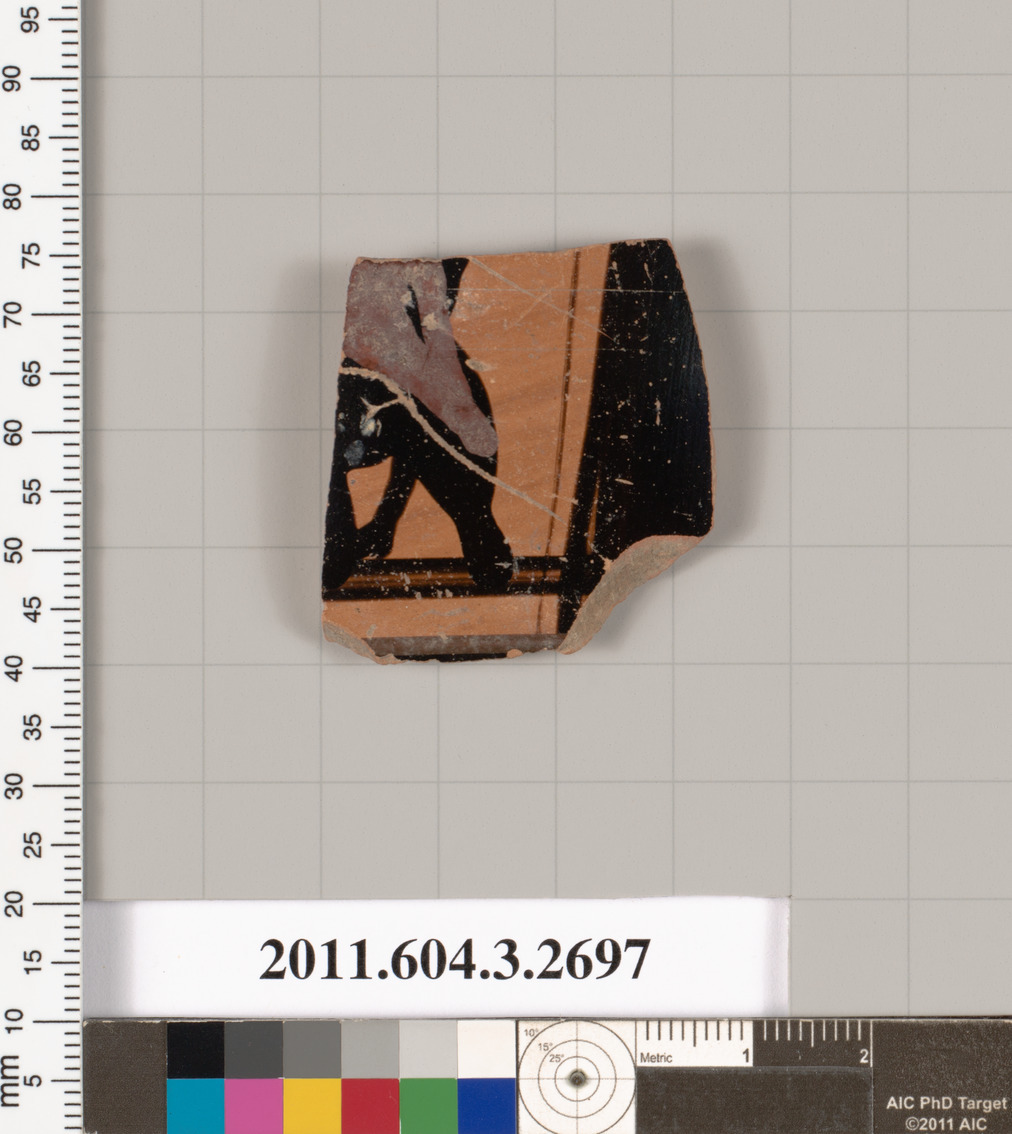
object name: oinochoe fragment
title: Terracotta fragment of an oinochoe (jug)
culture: greek, attic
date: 534-468 BCE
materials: terracotta